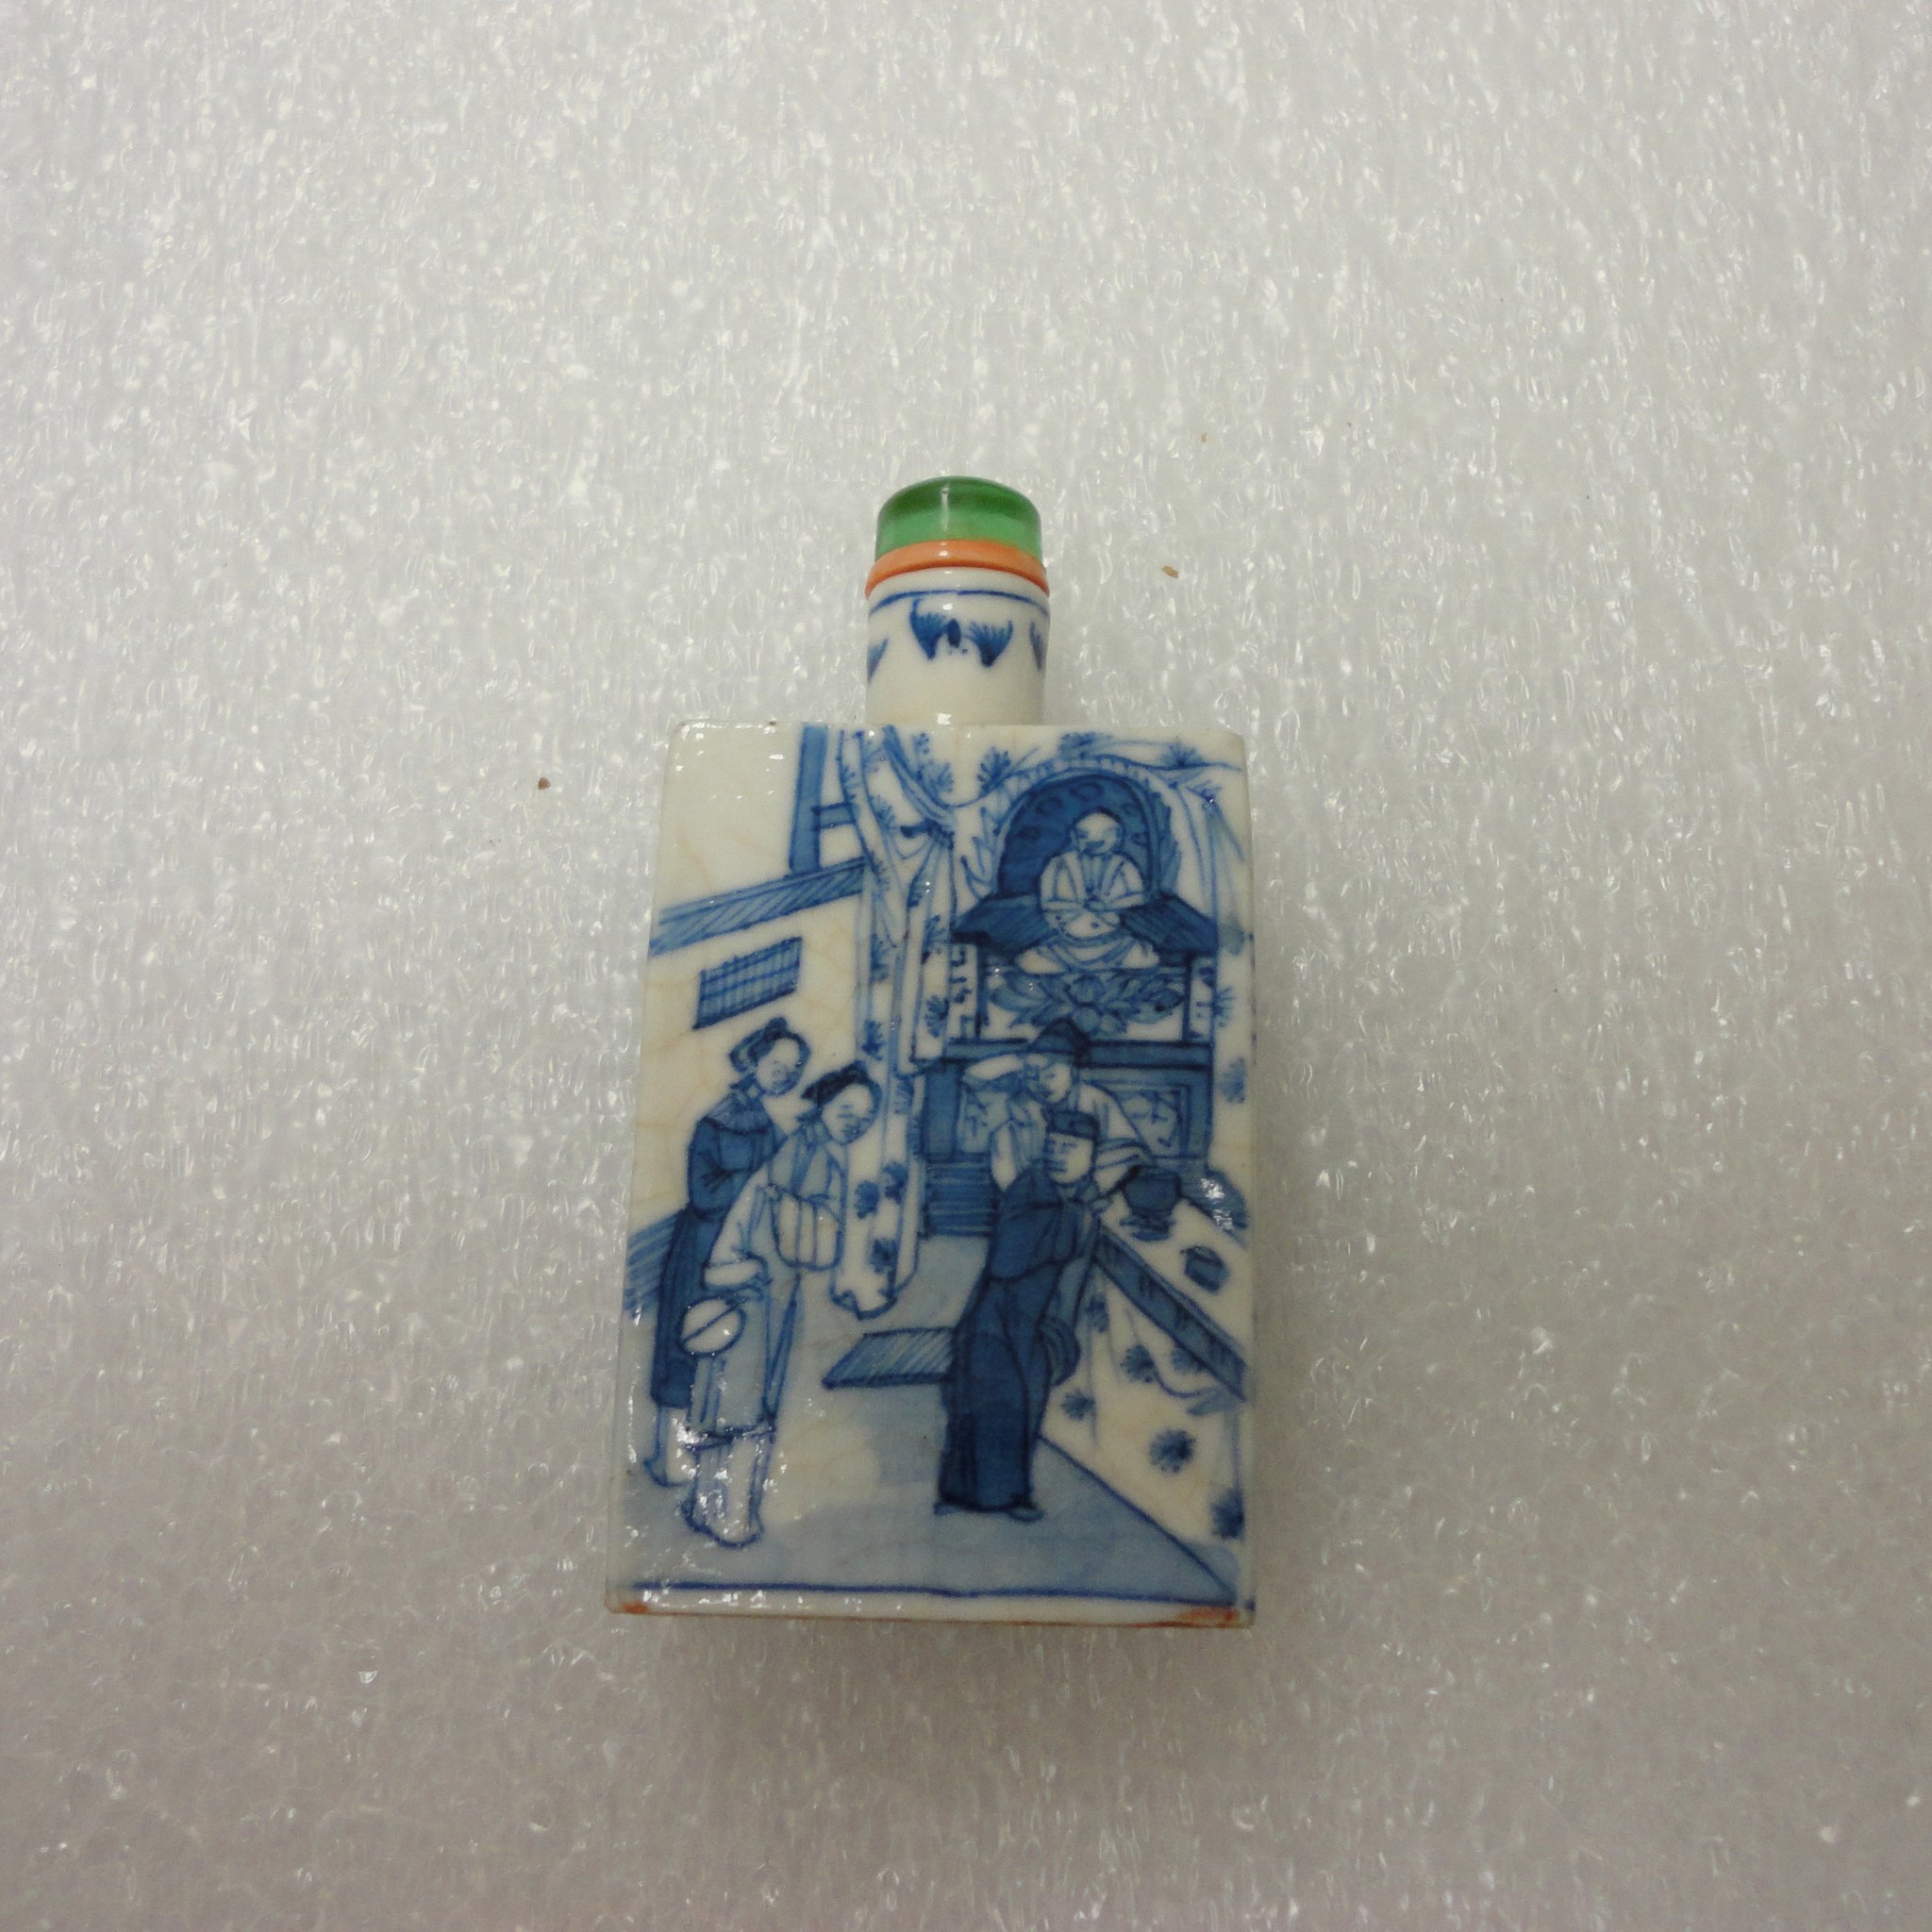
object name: snuff bottle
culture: chinese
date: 1801-1900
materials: porcelain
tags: human figures